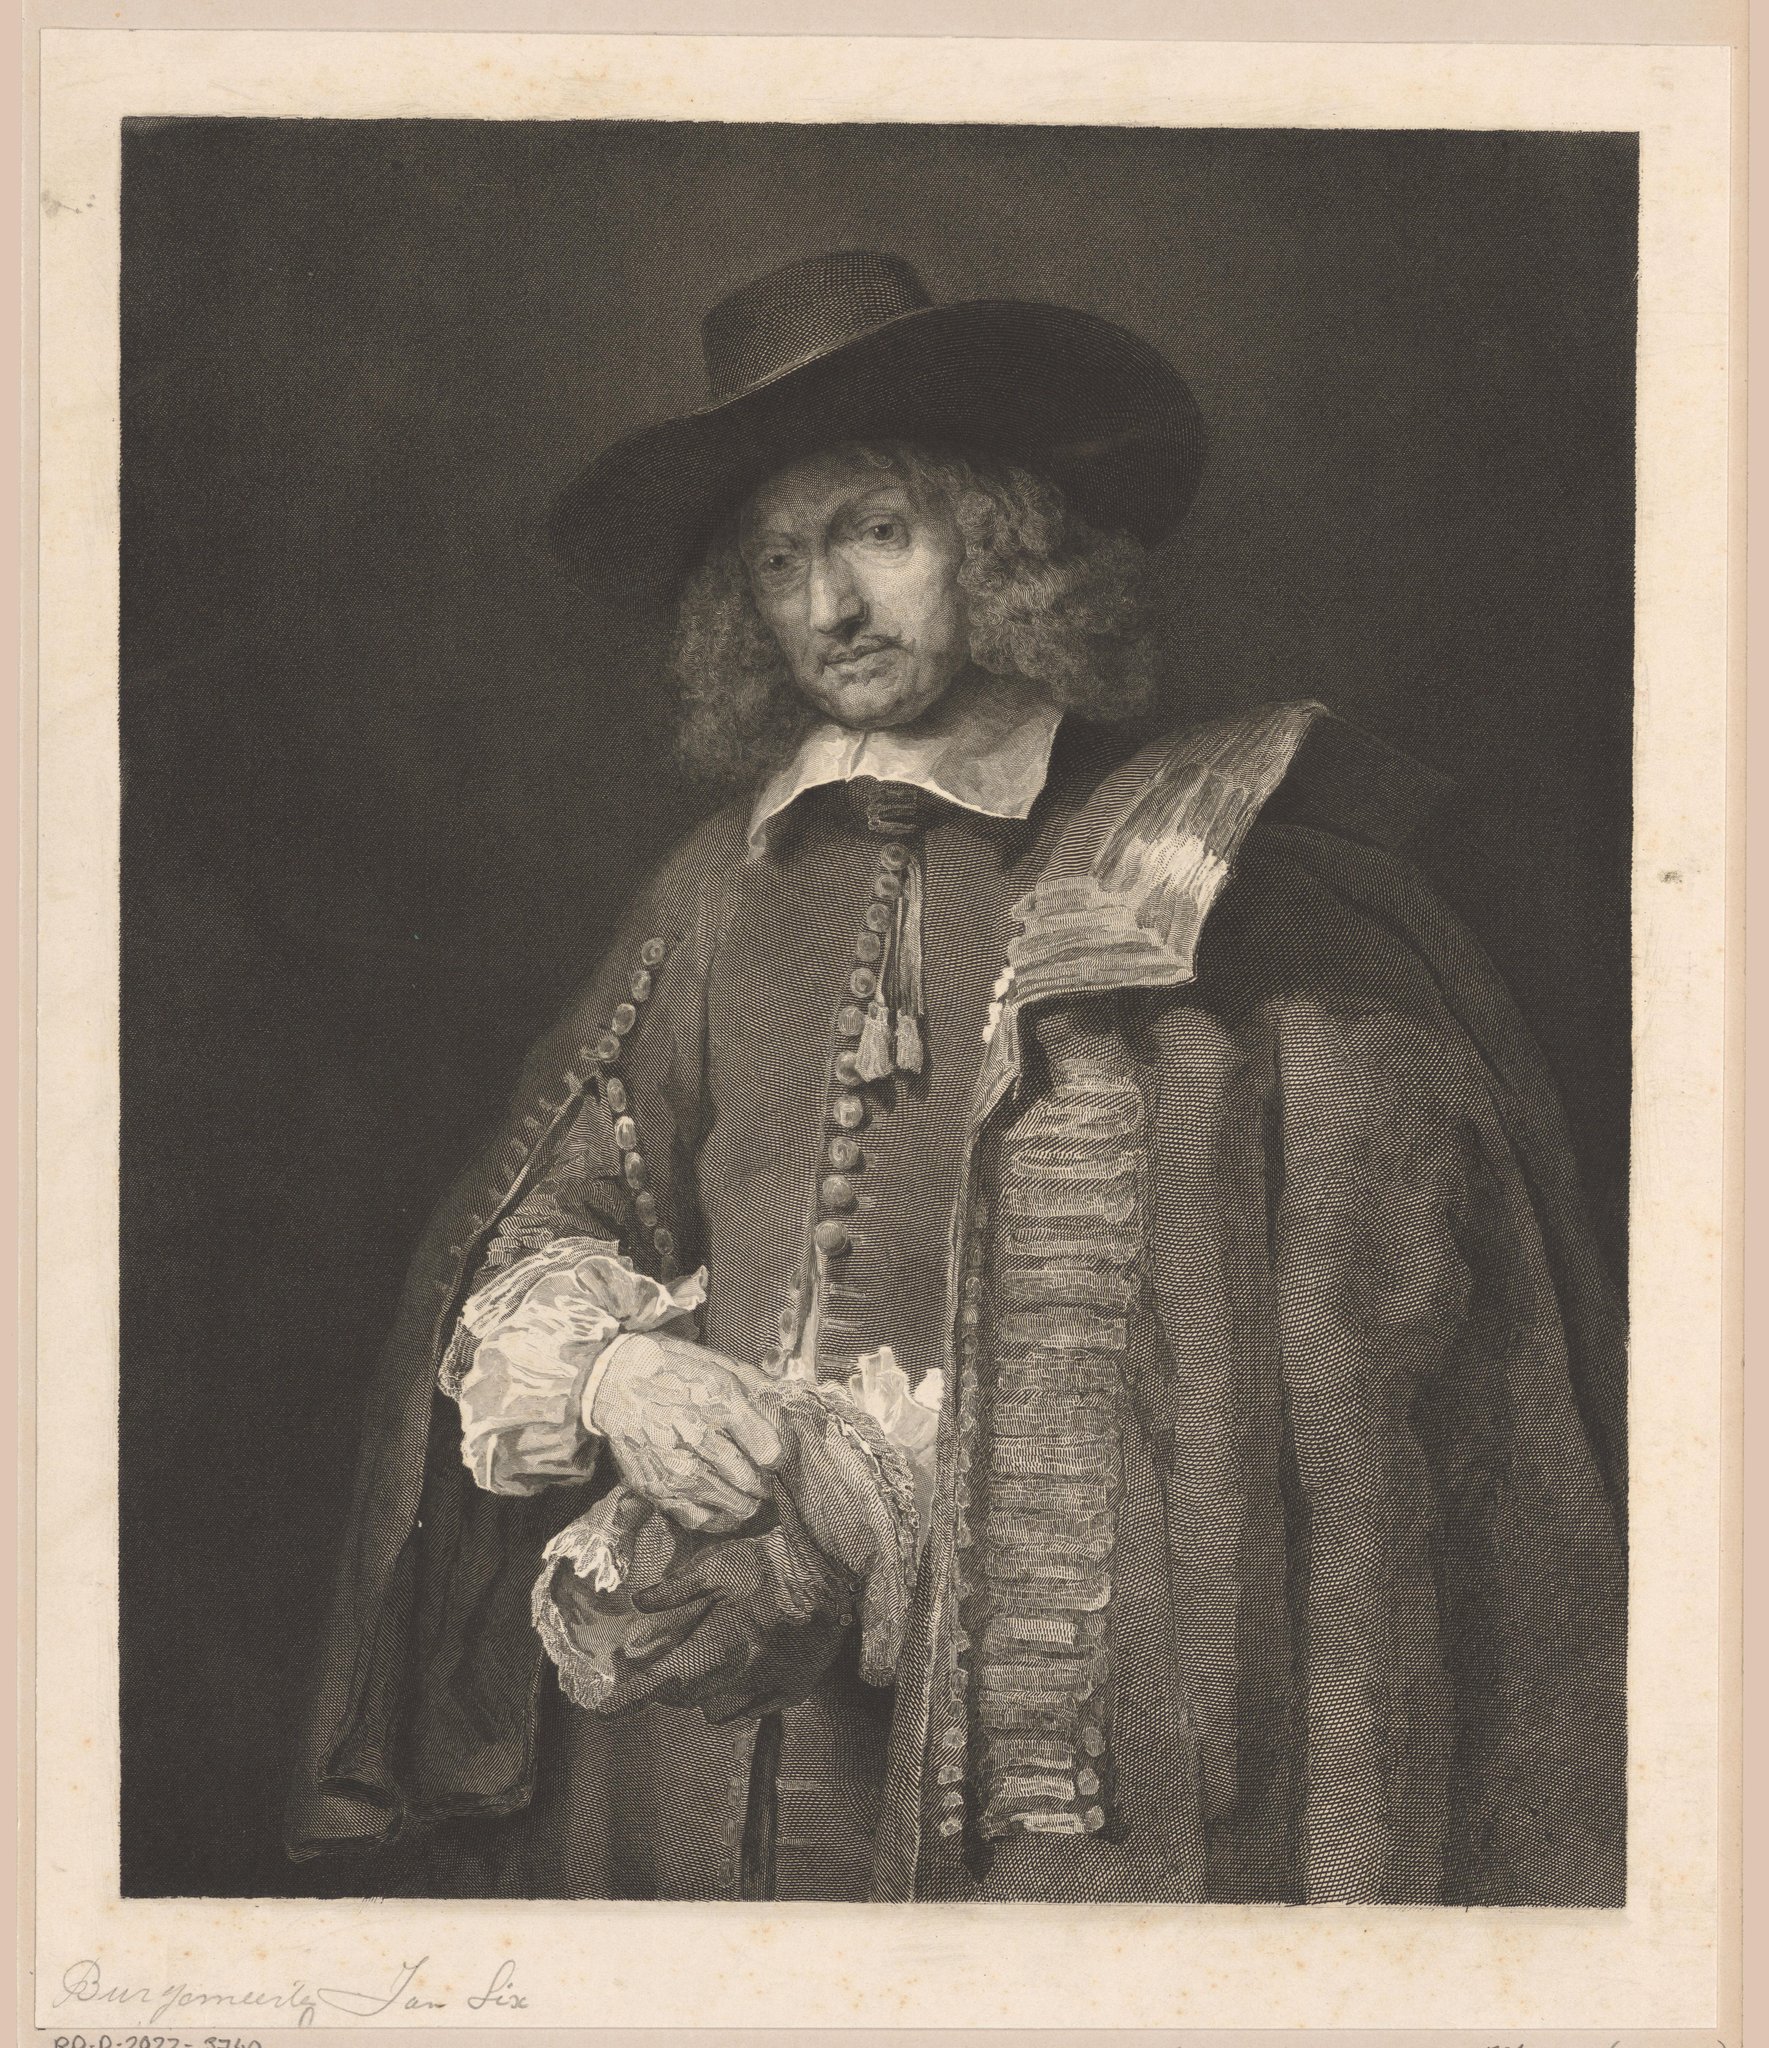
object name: print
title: Portret van Jan Six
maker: johann wilhelm kaiser (i)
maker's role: draughtsman, print maker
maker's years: 1813-1900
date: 1823-1853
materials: paper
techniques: engraving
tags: amsterdam, mayor, jan six (1618-1700), mayor, burgomaster, historical persons, art collector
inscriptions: inscription: ‘Burgemeester Jan Six’